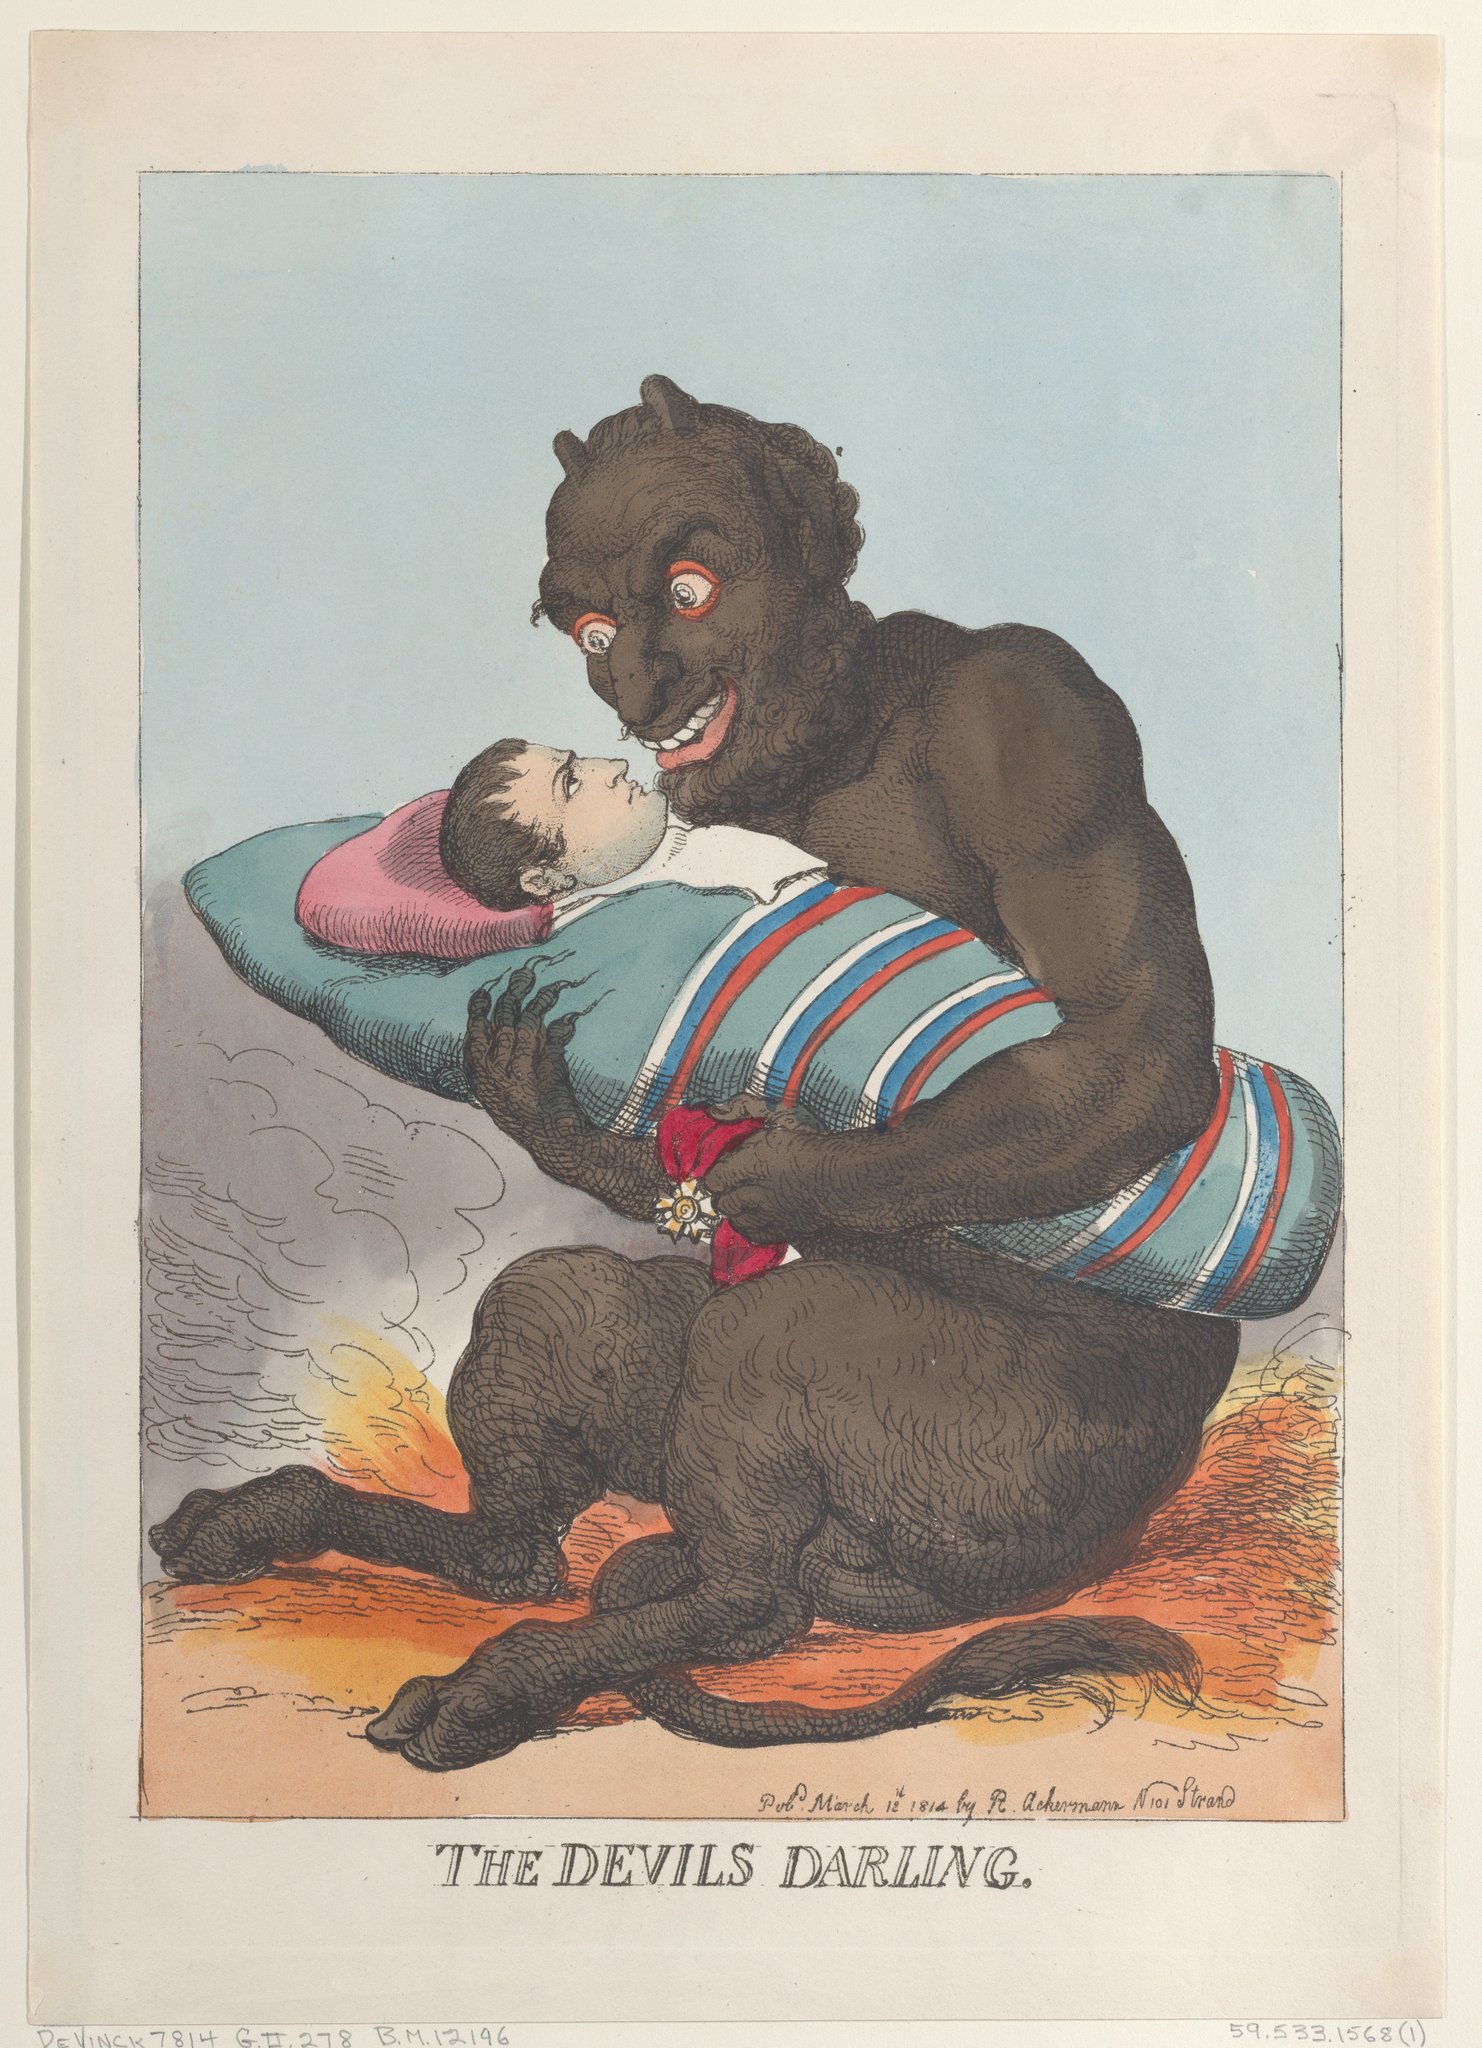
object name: print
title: The Devil's Darling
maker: thomas rowlandson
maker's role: artist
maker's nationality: british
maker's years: 1757-1827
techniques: etching, hand coloring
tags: satire,napoleon i,devil,politics